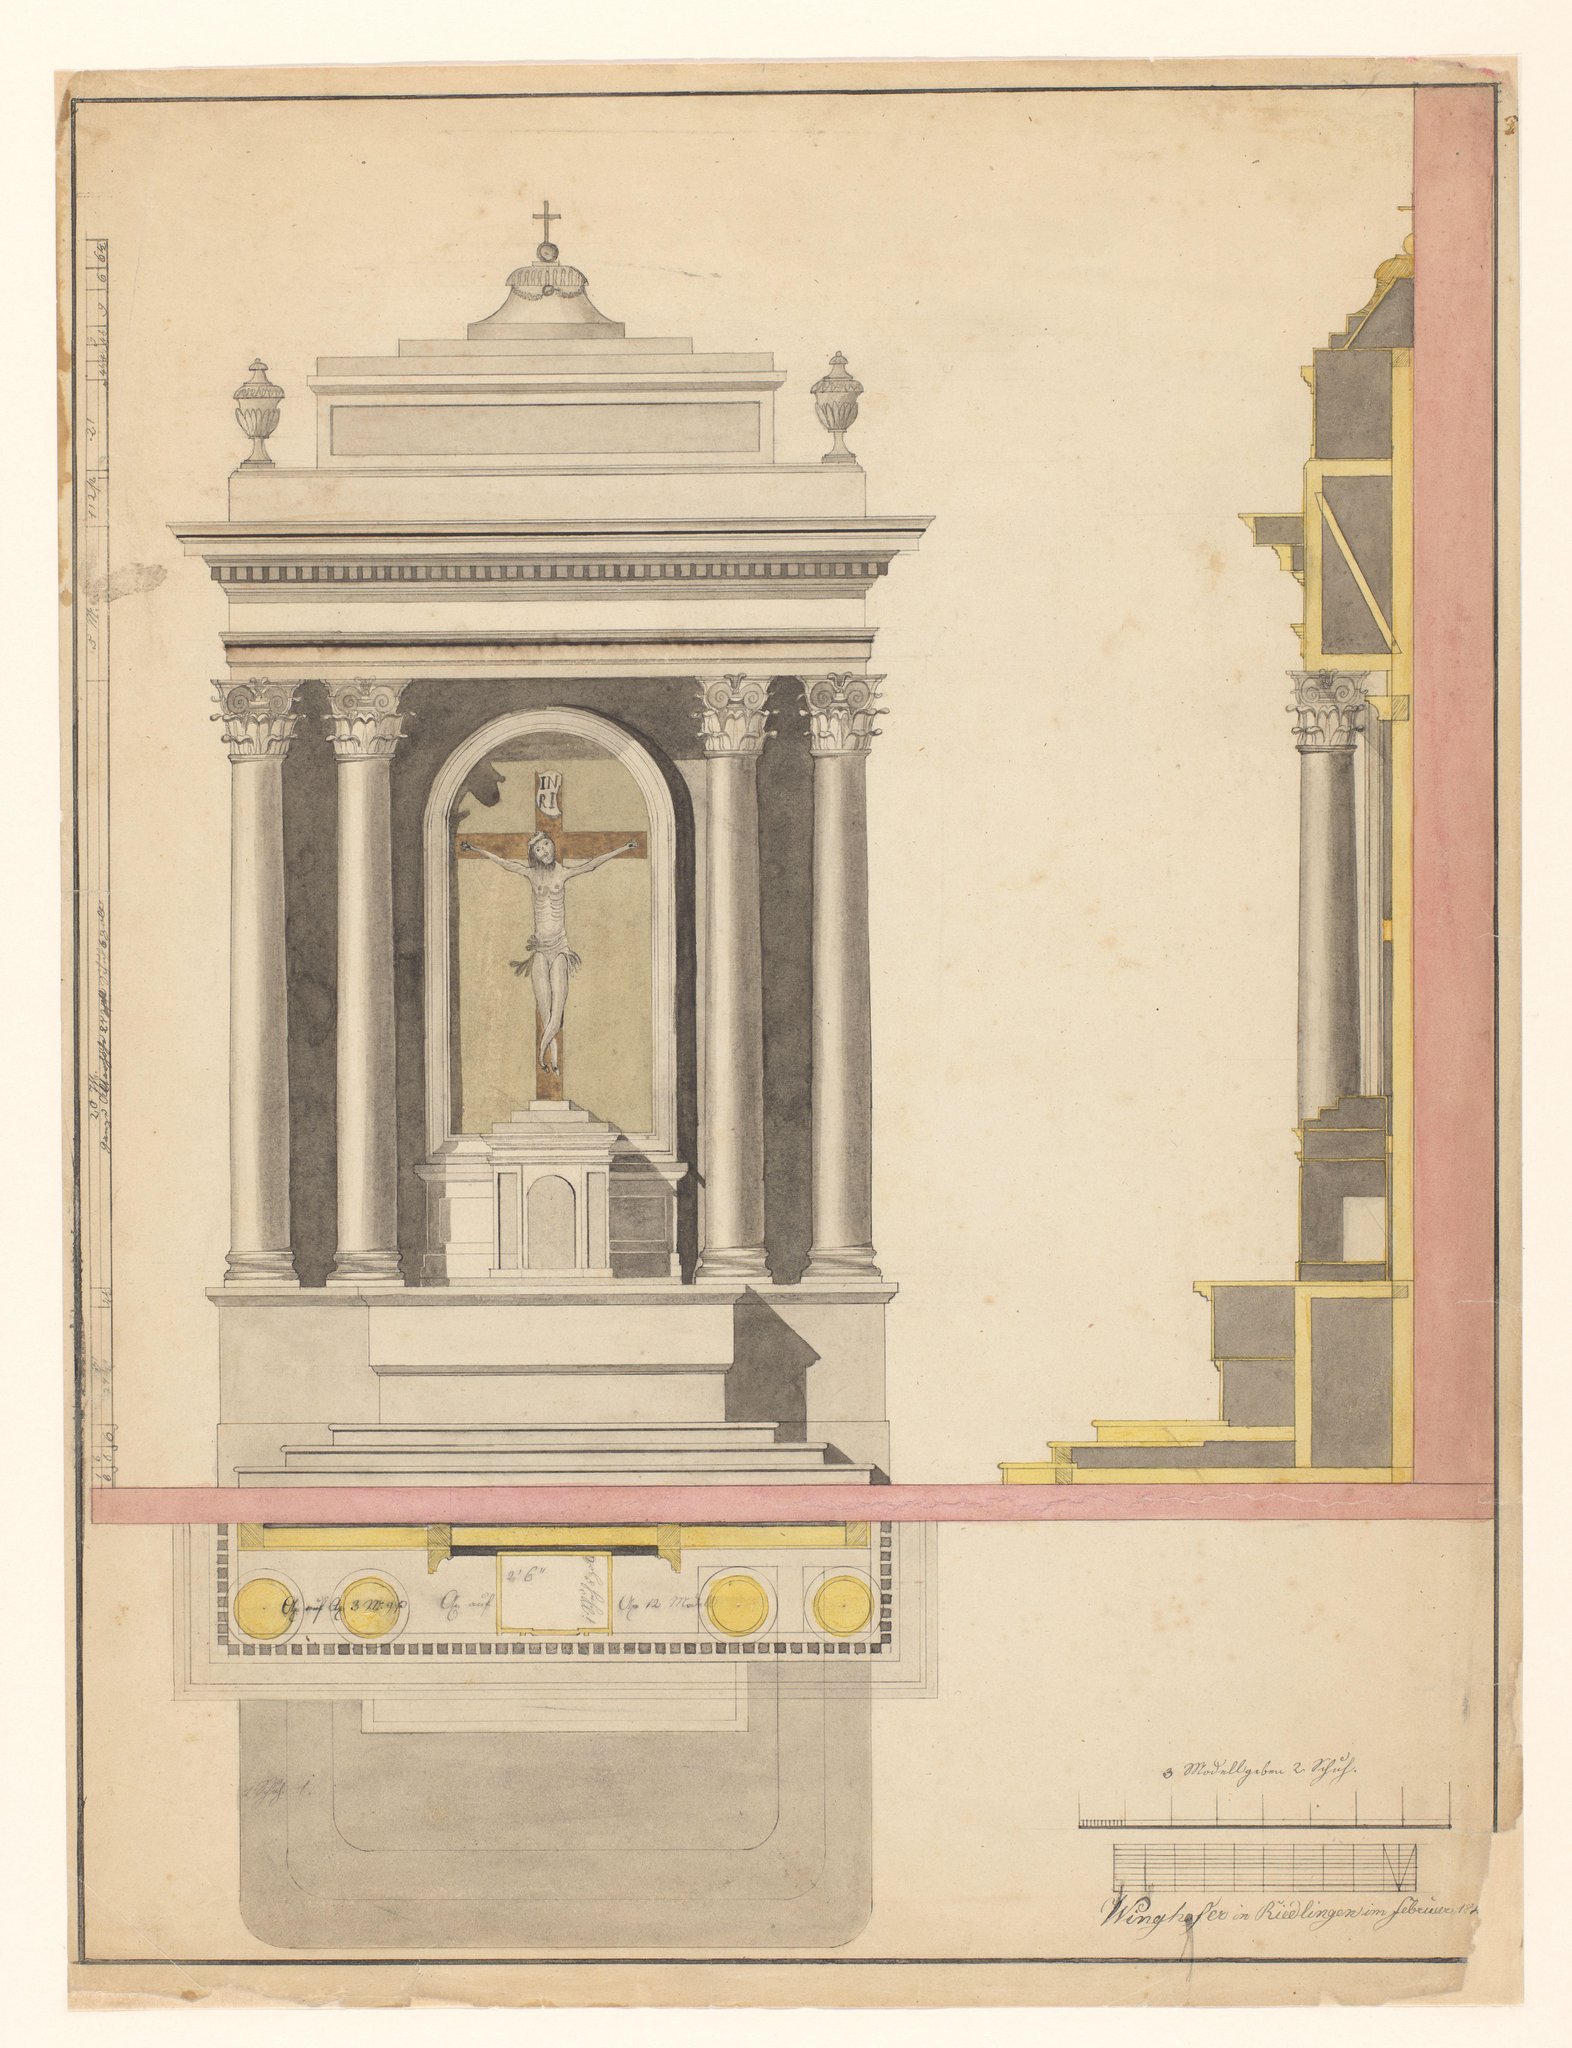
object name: drawing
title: Ontwerp voor een altaar met plattegrond en zijaanzicht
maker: b. winghofer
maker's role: draughtsman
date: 1847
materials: graphite, ink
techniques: drawing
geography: riedlingen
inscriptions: signature and date: ‘Winghofer in Riedlingen im februar 184[…]’, size: ‘maten’, size: ‘maatstaf met maten en ganzer Altarhöhe 27 Schuh 6 Zoll.’, size: ‘twee maatstaven met 3 Modull geben 2. Schuh.’